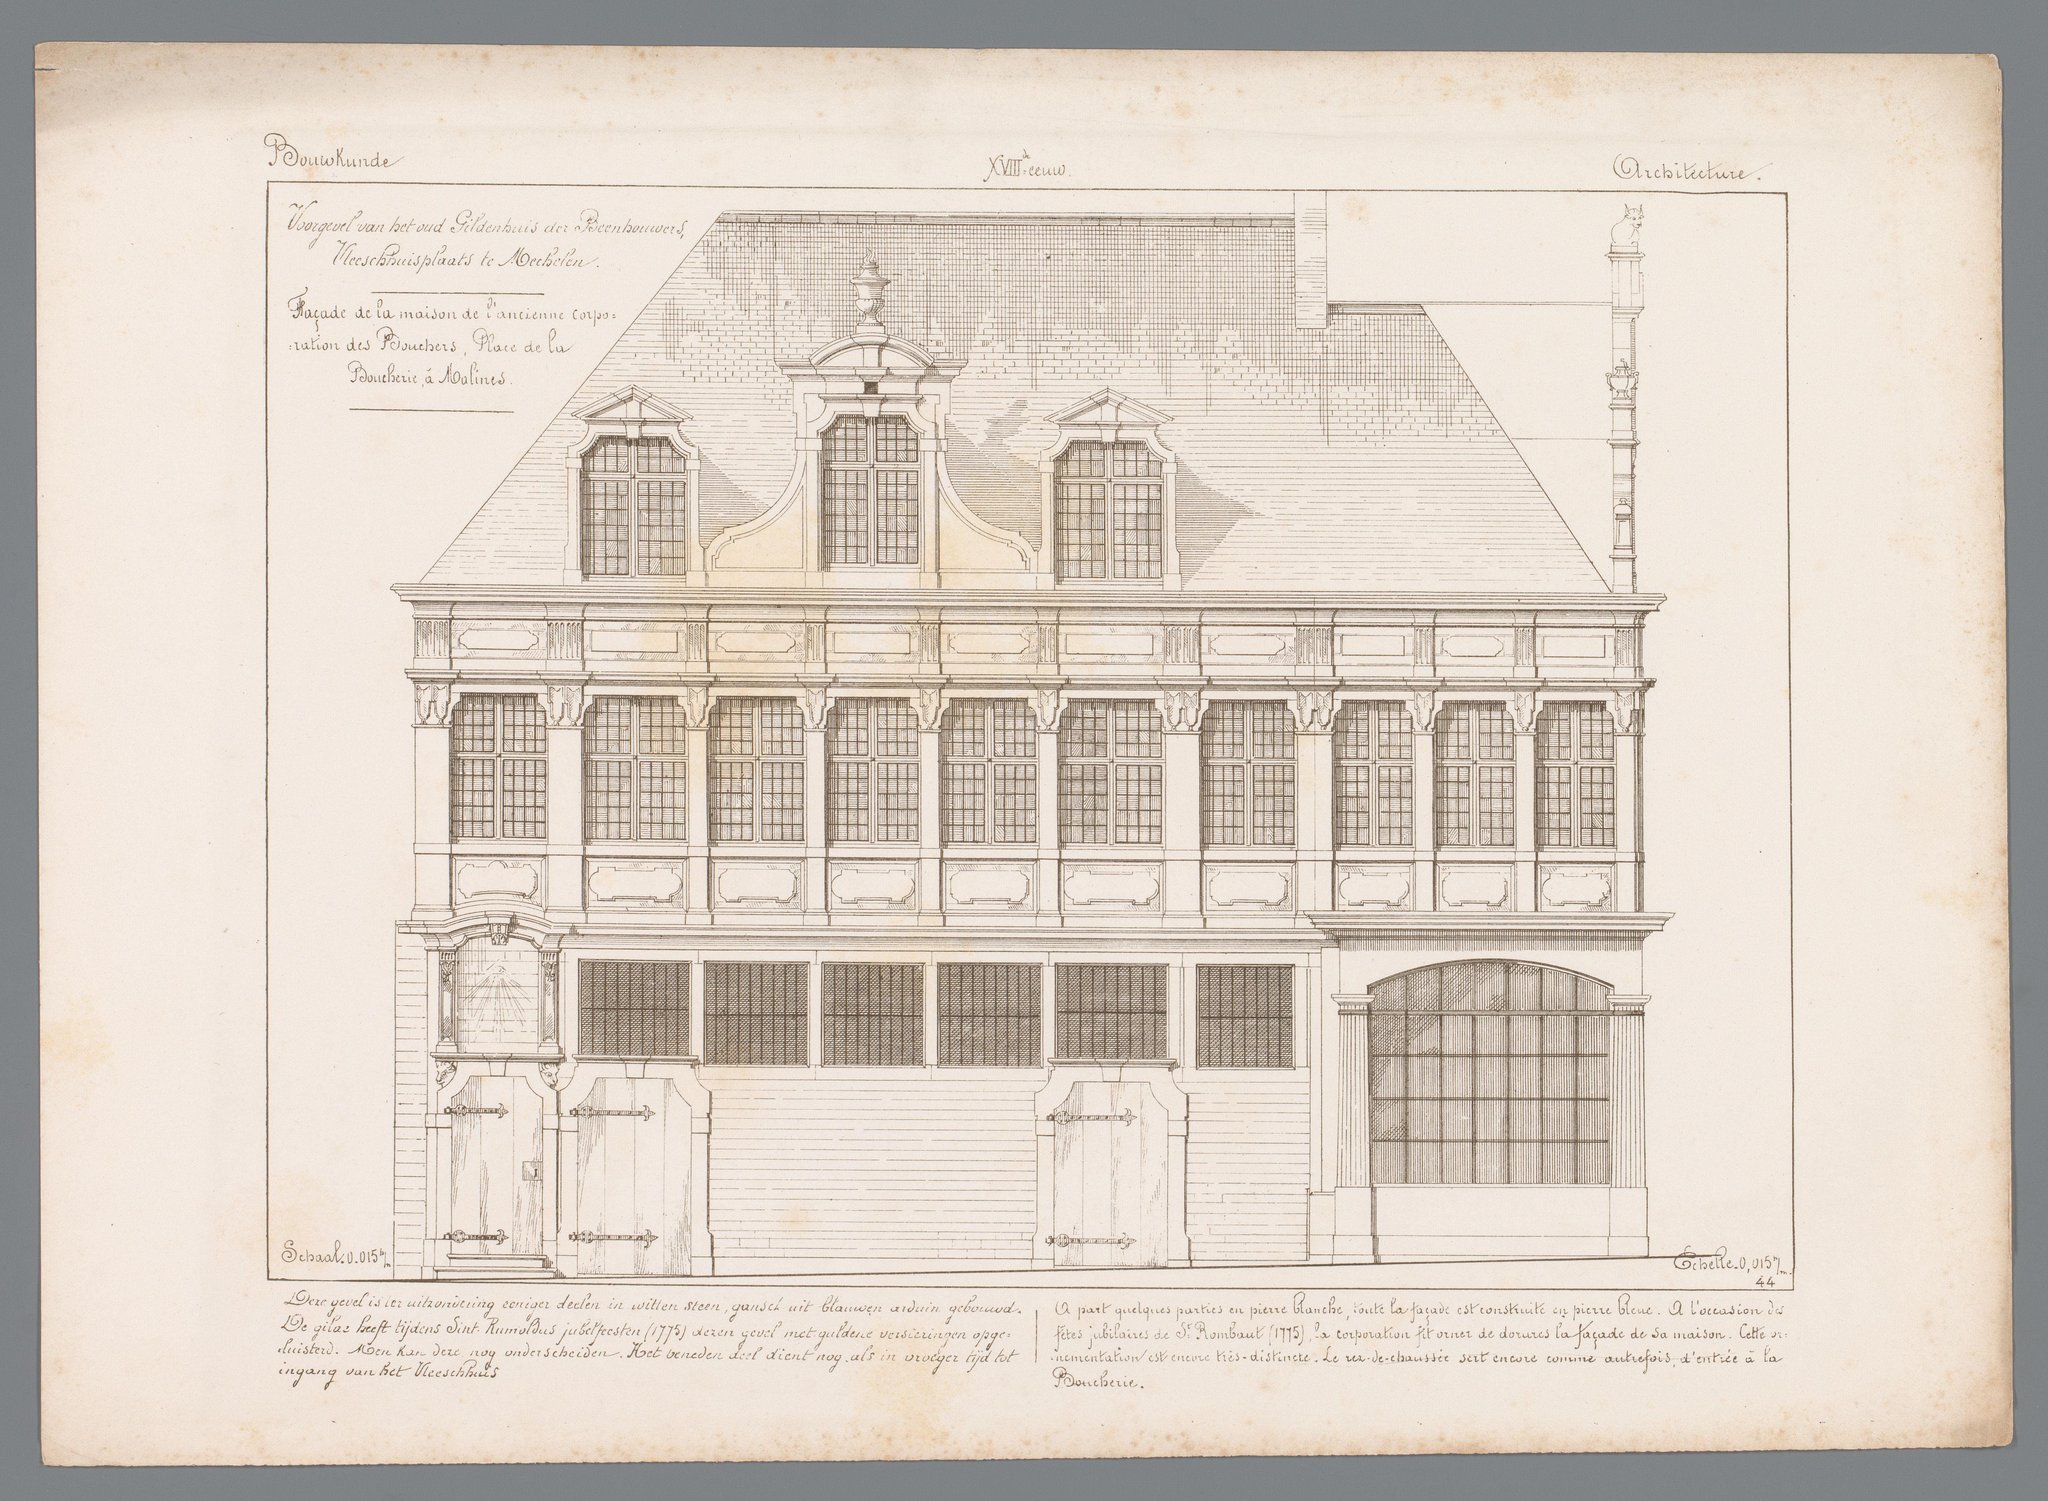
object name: print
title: Voorgevel van het oude Gildehuis der Beenhouwers te Mechelen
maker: Anonymous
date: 1800-1899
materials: paper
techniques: lithograph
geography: liège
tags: guildhall, front façade, mechelen